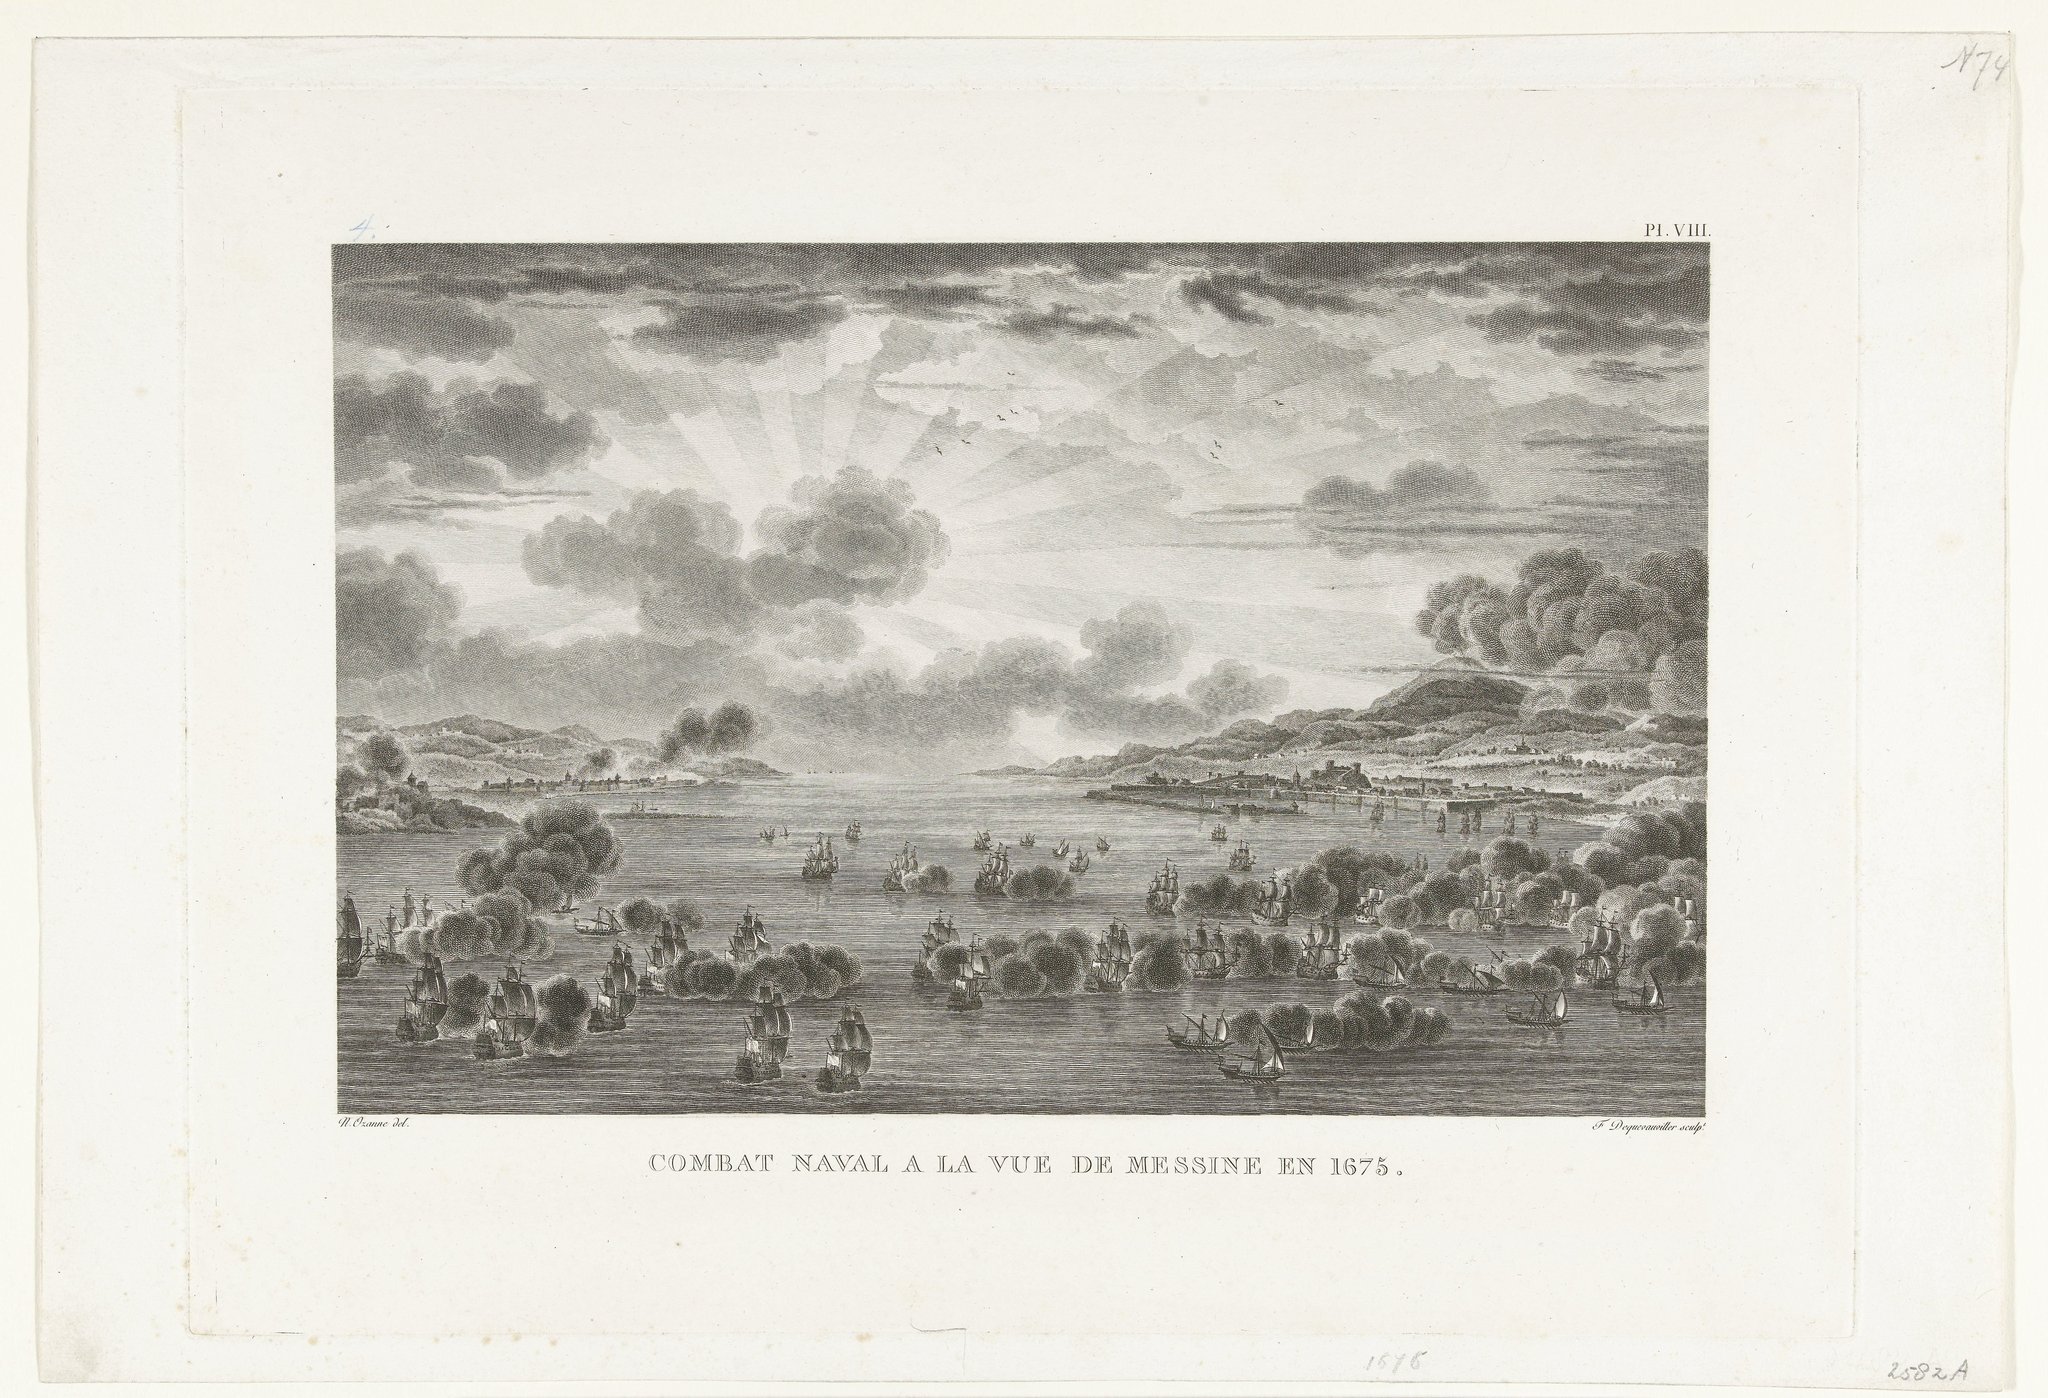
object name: print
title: Zeeslag bij Stromboli, 1676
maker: nicolas marie ozanne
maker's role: draughtsman, print maker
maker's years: 1728-1811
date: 1755-1811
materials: paper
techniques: etching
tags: flushing, michiel adriaenszoon de ruyter, paris, battle (+ naval force), battle of stromboli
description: Zeeslag bij Stromboli op 8 januari 1676 tussen de vloot van de Republiek onder Michiel Adriaenszoon de Ruyter en een Franse vloot onder Abraham Duquesne. Gemerkt rechtsboven: Pl. VIII.